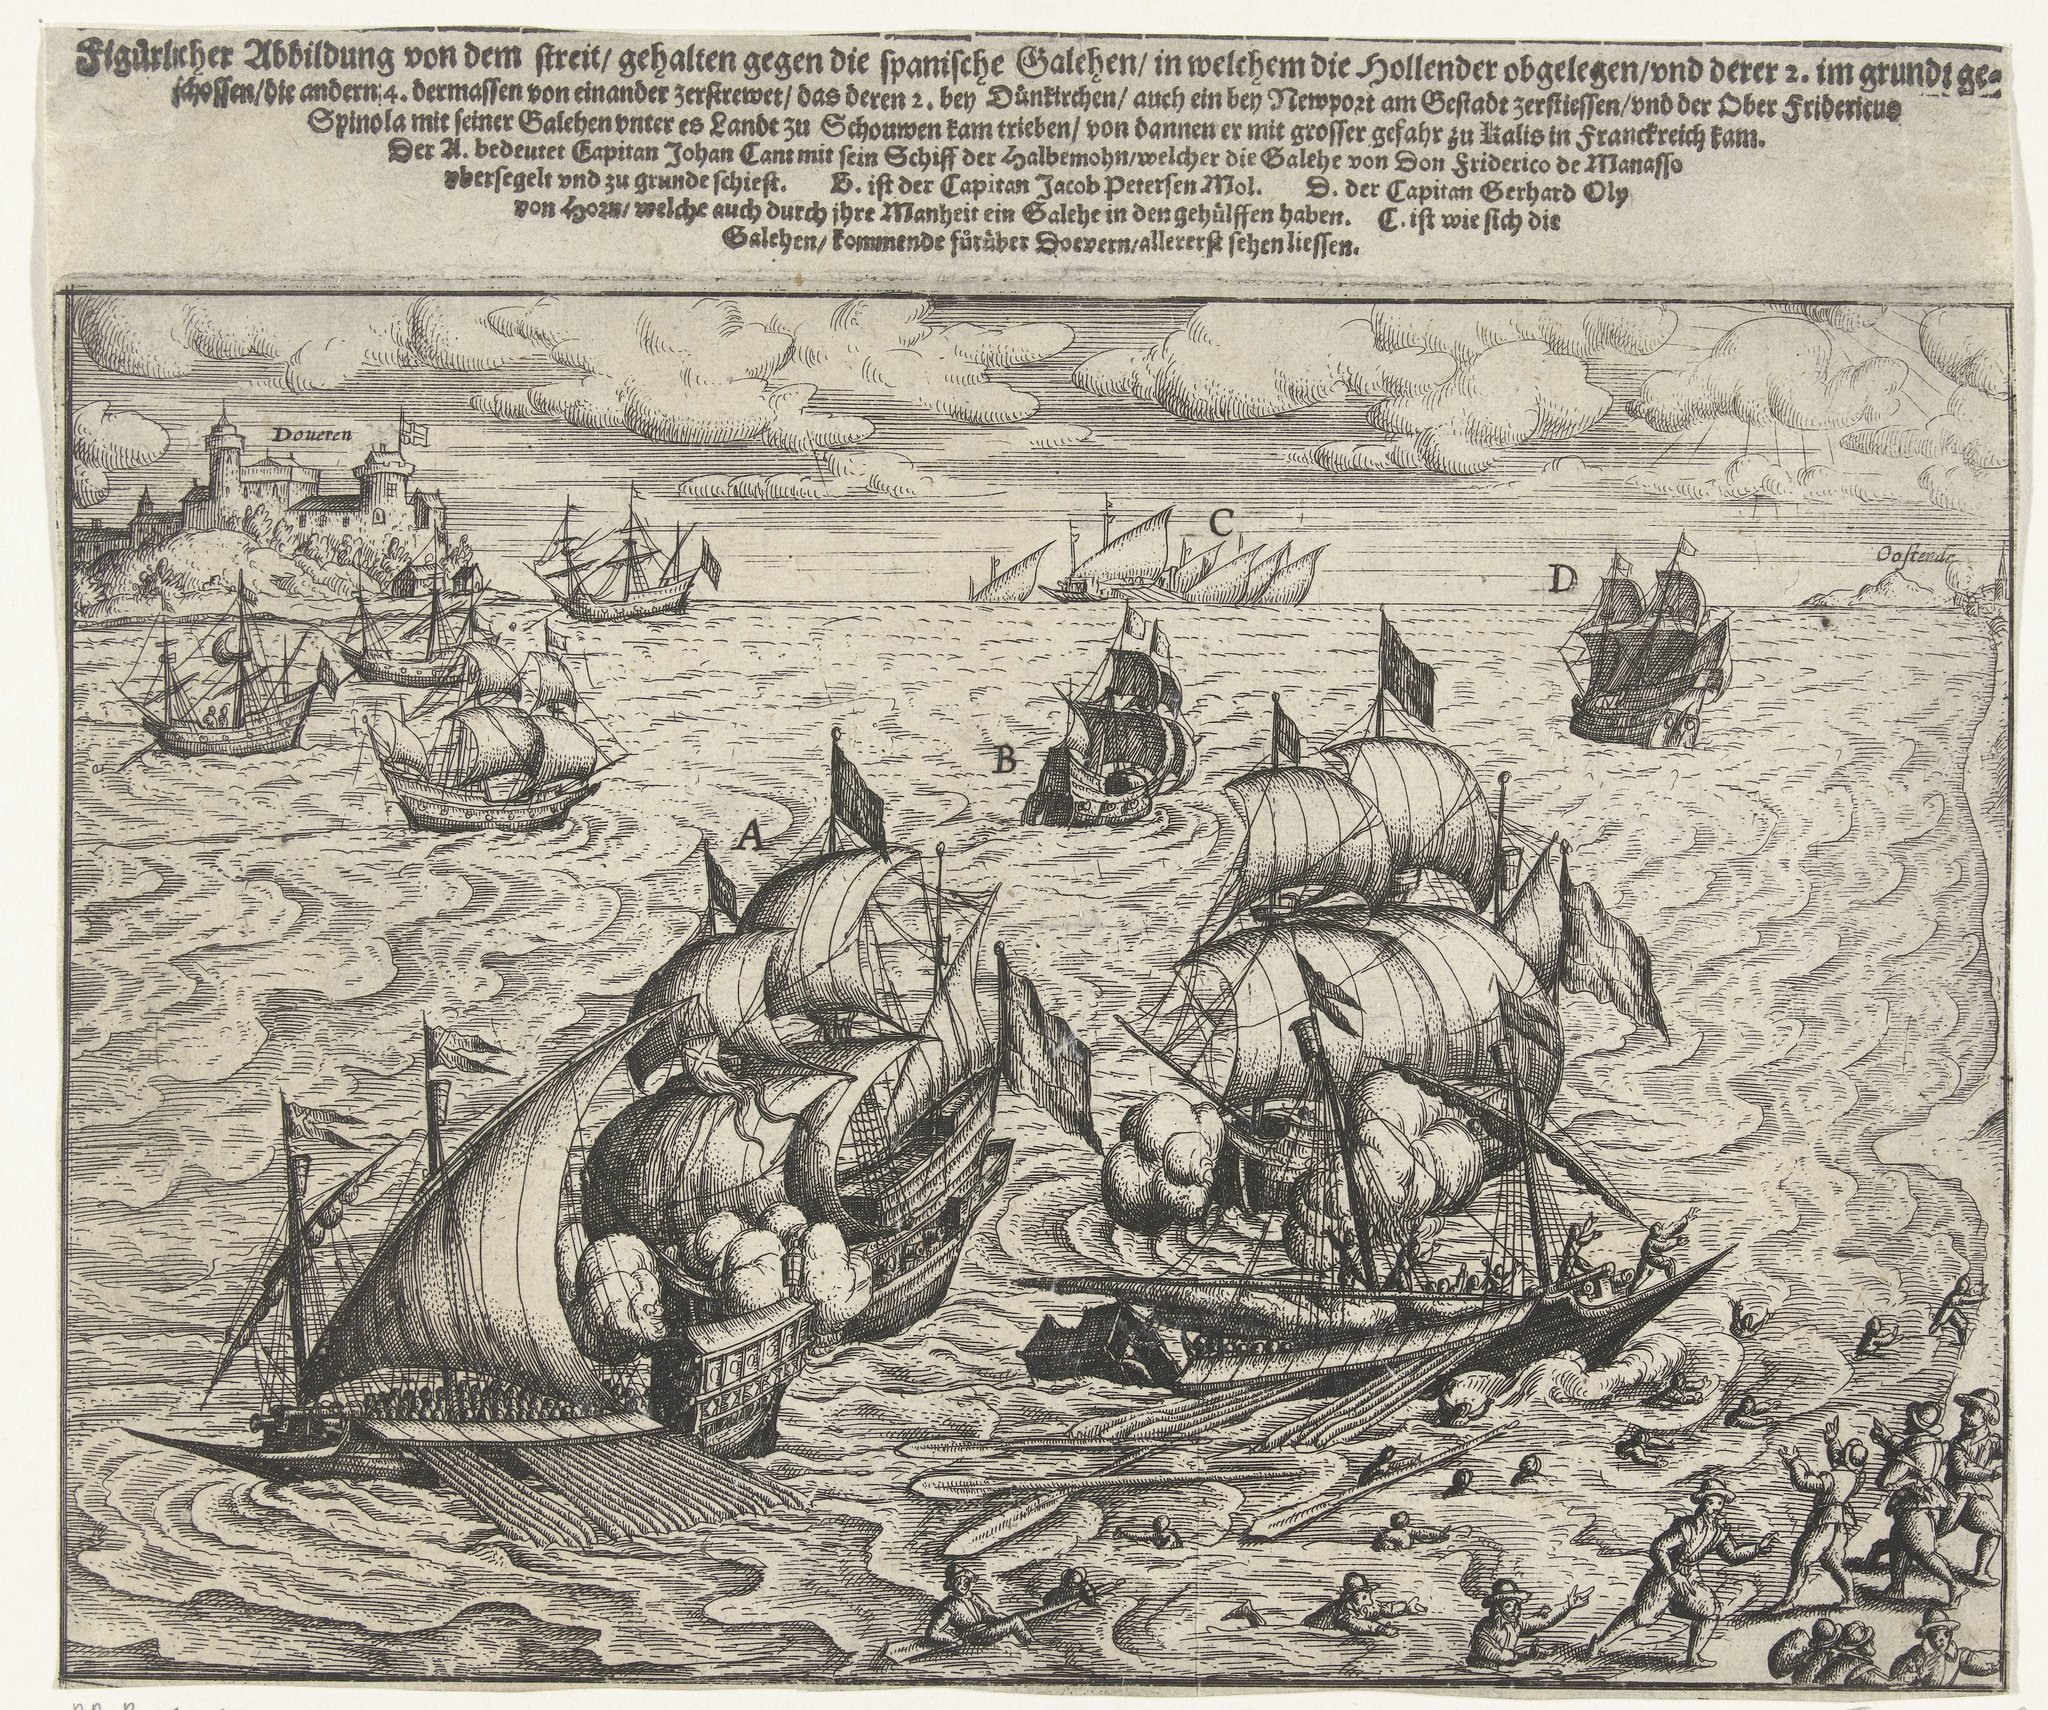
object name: print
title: Figurlicher Abbildung von dem streit / gehalten gegen die spanische Galehen / in welchem die Hollender obgelegen (...)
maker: Anonymous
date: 1602-1604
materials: paper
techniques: etching, letterpress printing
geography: germany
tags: battle (+ naval force), warfare; military affairs (+ oared ships, e.g.: galley), trireme, galley, english channel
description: Zeeslag waarbij de zes Spaanse galeien van Spinola in het Kanaal worden verslagen door de Staatse vloot, 3 oktober 1602. Op de voorgrond kan een deel van de bemanning van de gezonken schepen de Vlaamse kust bereiken. Links in de verte de Engelse kust met de plaats Dover, rechts Oostende. Met titel en opschrift van 7 regels in het Duits apart gedrukt boven de prent.